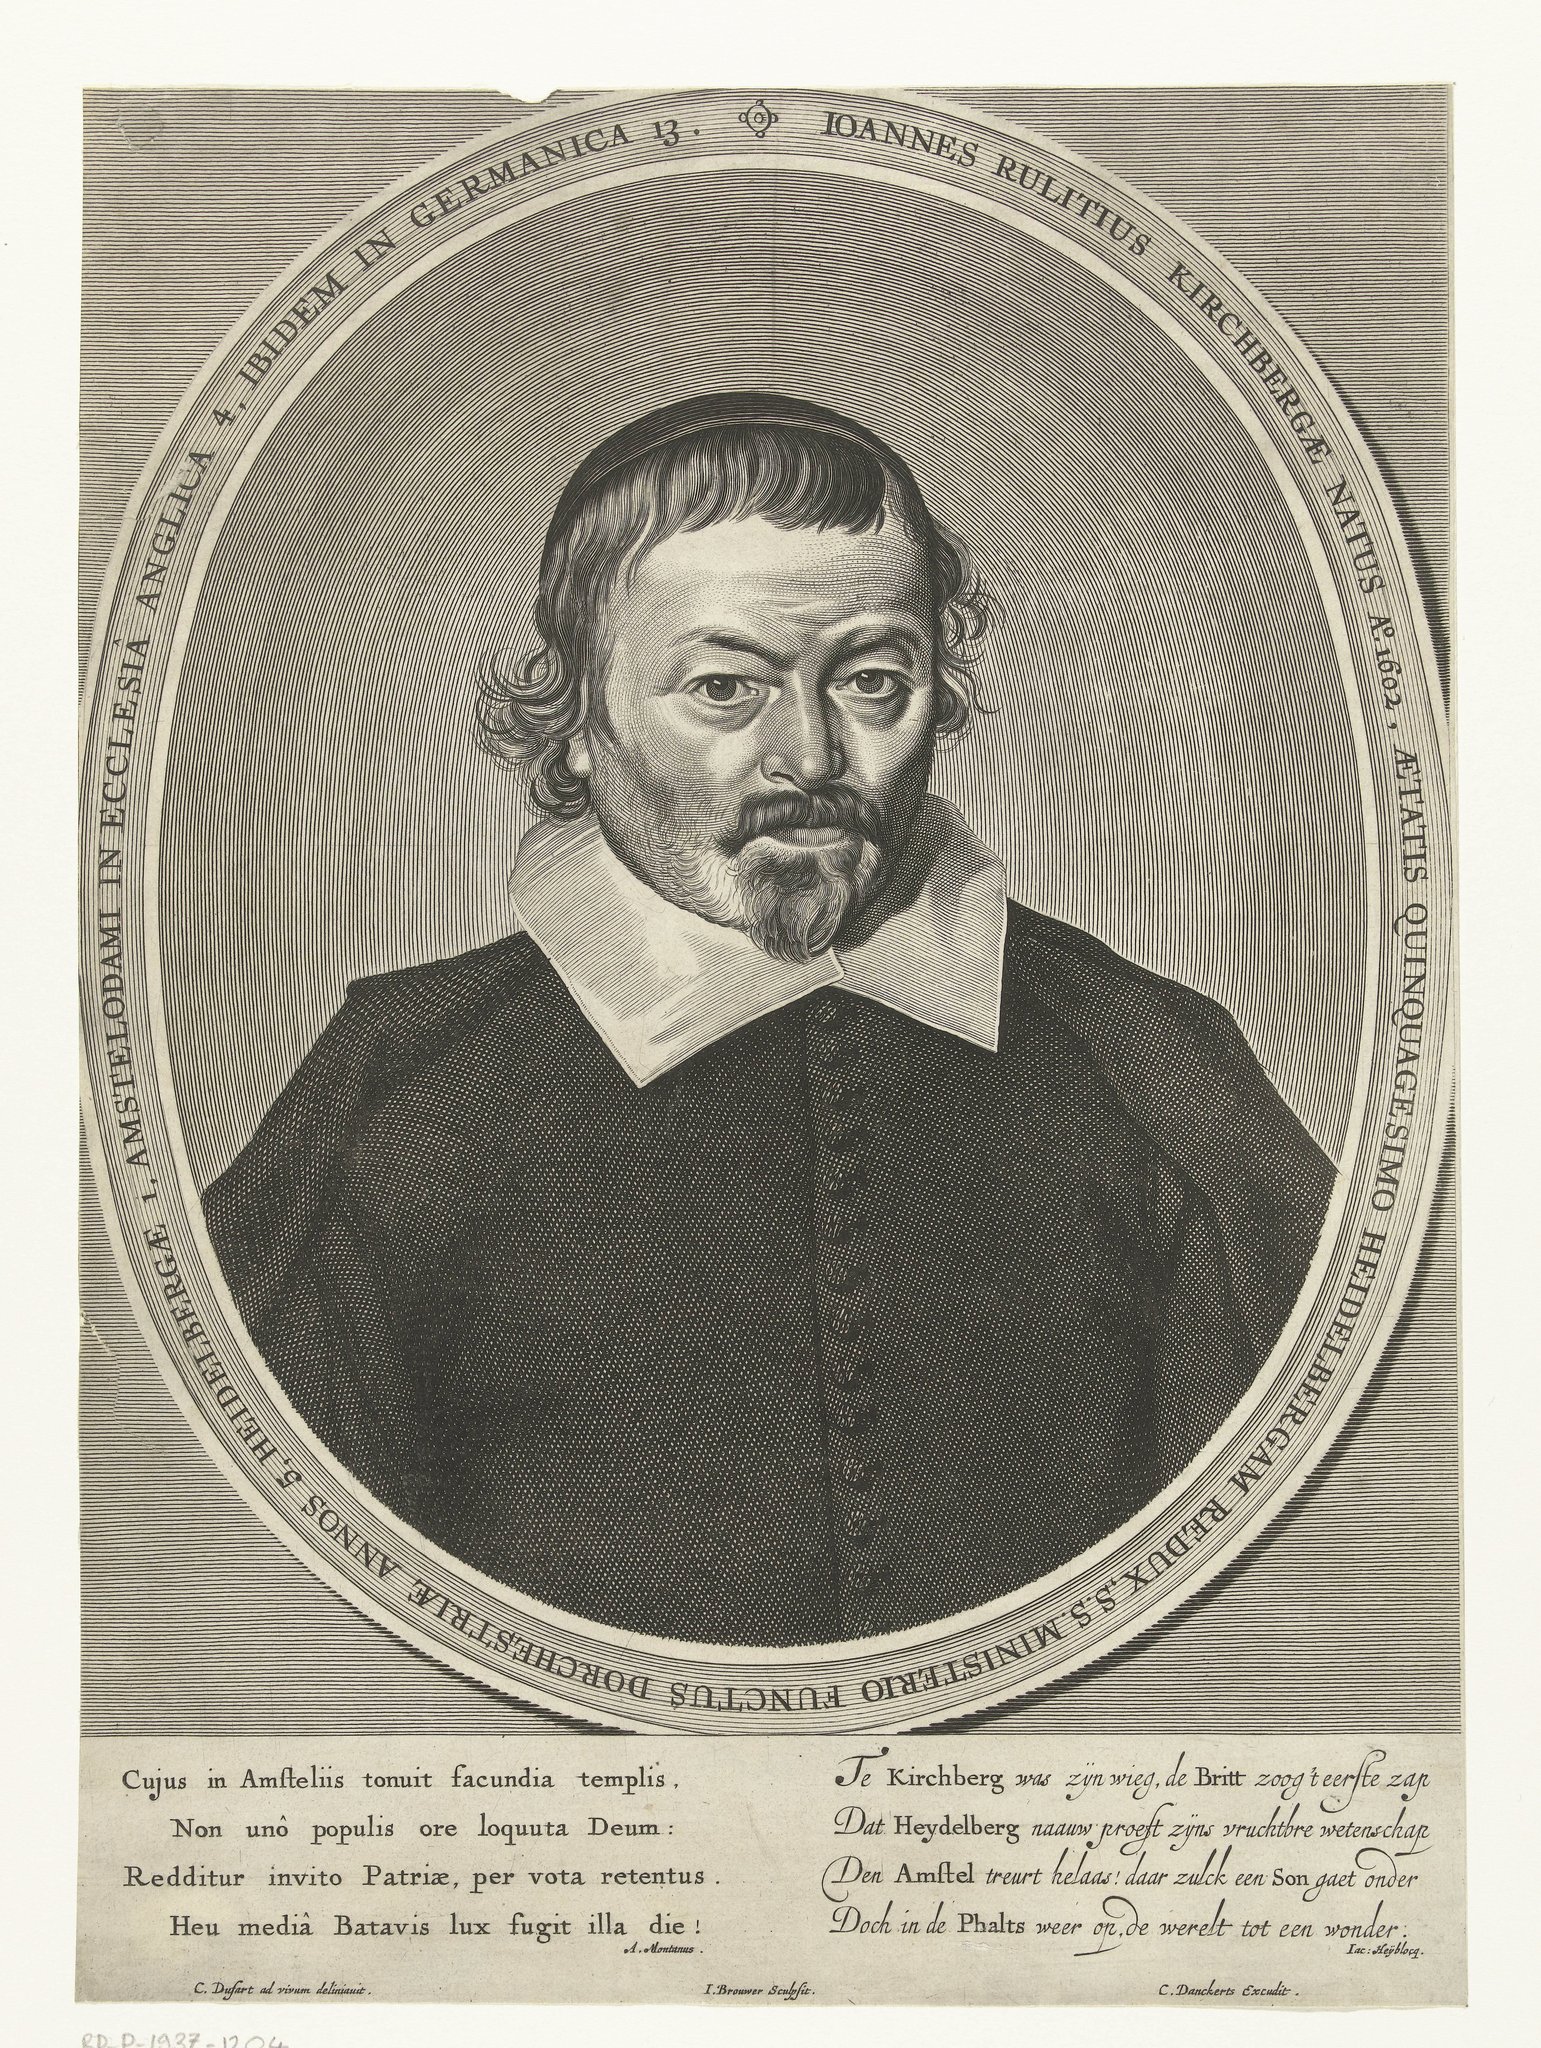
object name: print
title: Portret van de predikant Johannes Rulitius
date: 1652-1656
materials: paper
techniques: engraving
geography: amsterdam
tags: kirchberg, predikant, johannes rulitius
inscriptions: collector's mark: Lugt 2228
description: In het opschrift rond de prent wordt de leeftijd van hier geportretteerde Johannes Rulitius (1602-1666) aangeduid als 'aetatis quinquigesimo', ofwel 50 jaar, de leeftijd die hij in 1652 bereikte. De prent zal rond die tijd zijn gemaakt. Daarmee is Cornelis Dusart (1660-1704) als maker van de ontwerptekening uitgesloten, evenals Cornelis Danckerts II (1664-1717) als uitgever. De ontwerper is Christiaen Jansz. Dusart, van wie meer van dergelijke ontwerpen bekend zijn, en Cornelis Danckerts (1604-1656).